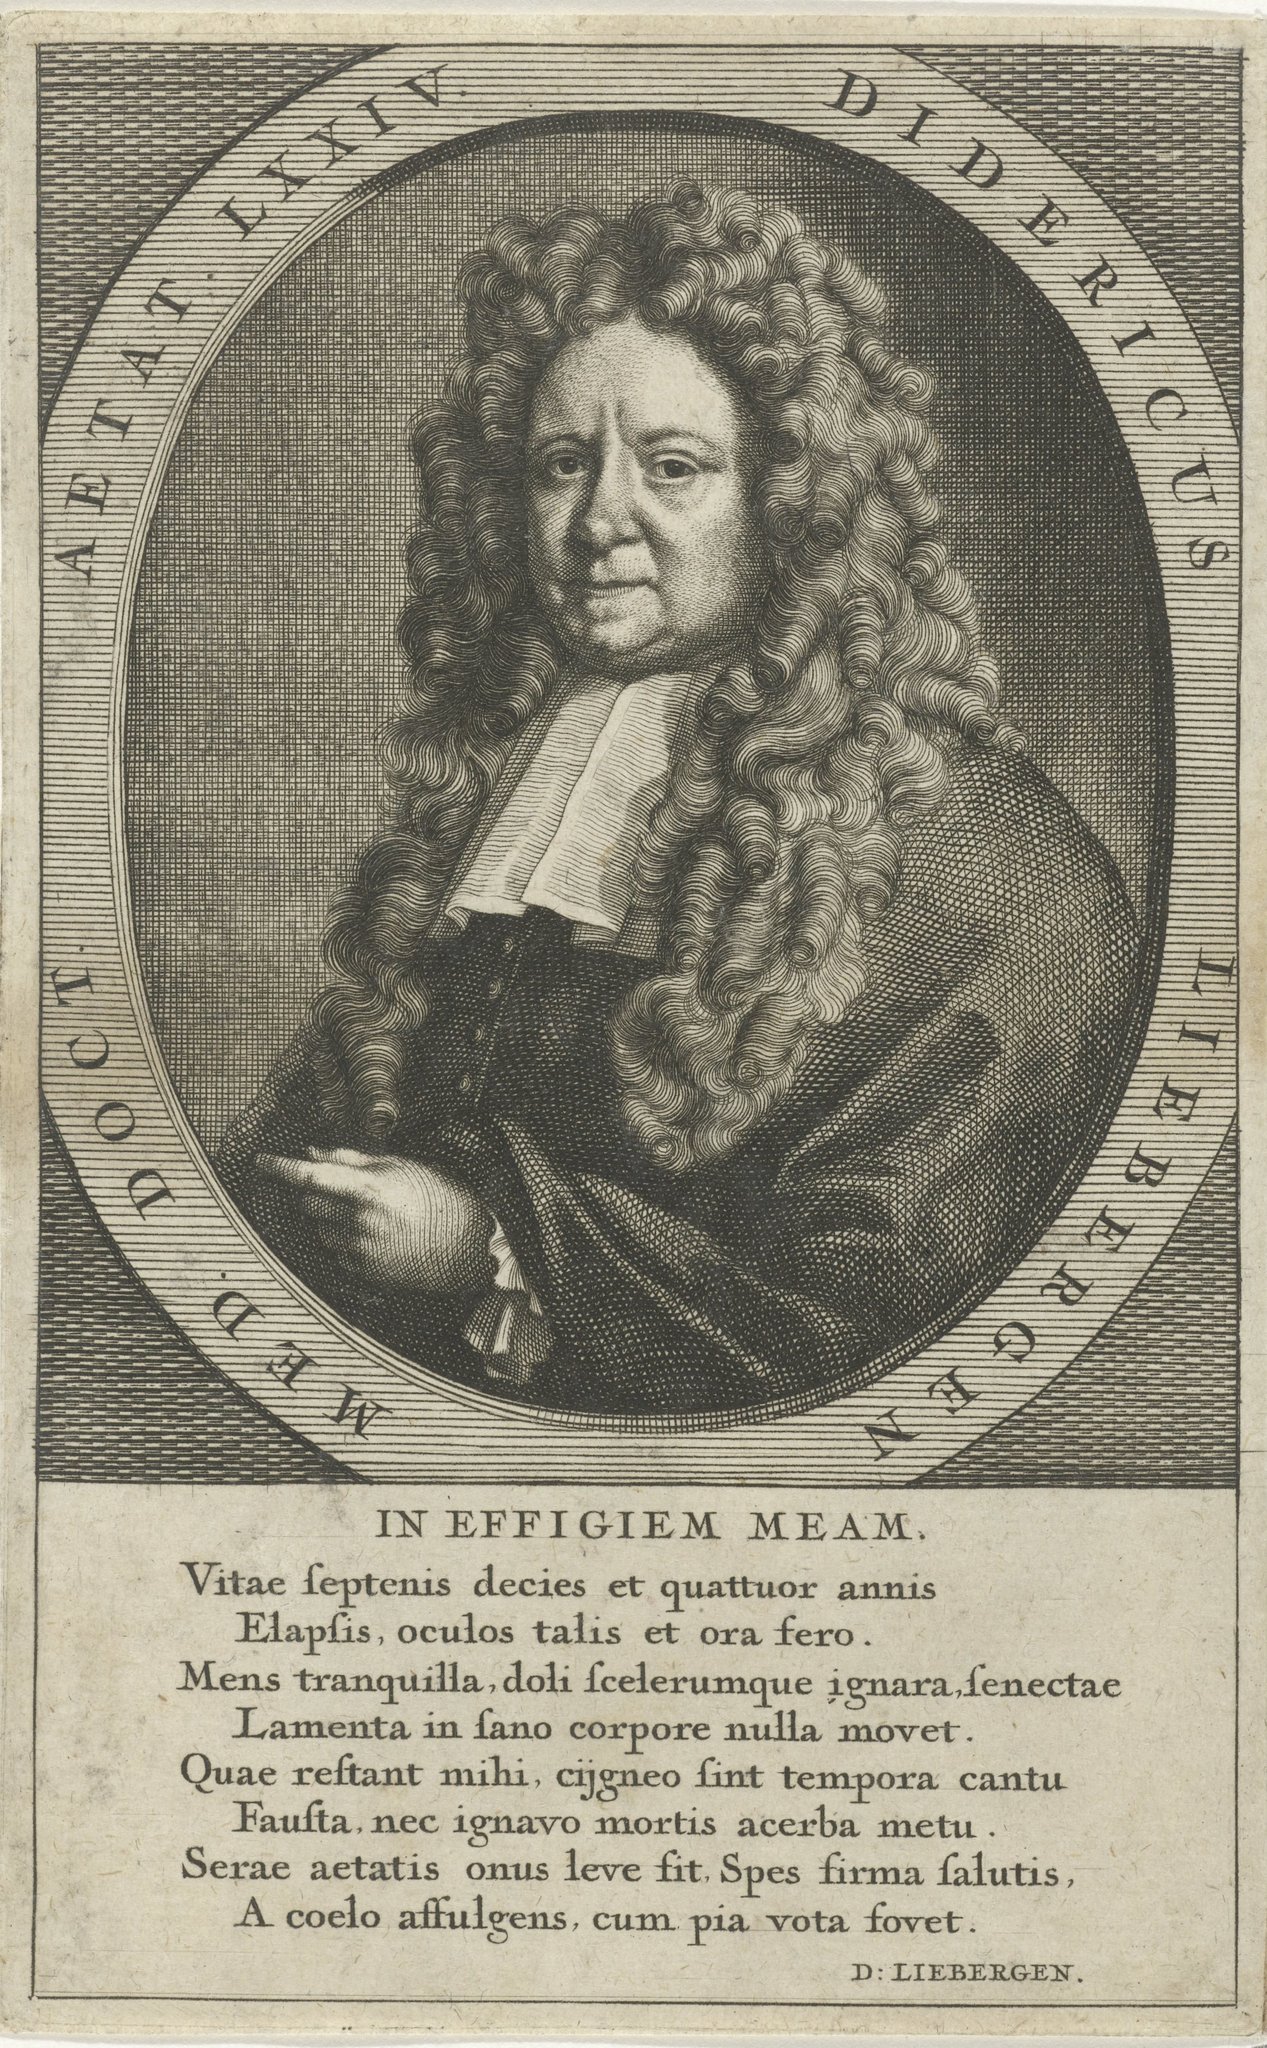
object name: print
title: Portret van Didericus Liebergen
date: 1708-1780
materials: paper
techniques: engraving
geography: amsterdam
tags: didericus liebergen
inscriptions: collector's mark: Lugt 2228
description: Portret naar links van Didericus Liebergen op 74-arige leeftijd in een ovaal met randschrift in het Latijn. Onder het portret negen regels in het Latijn.